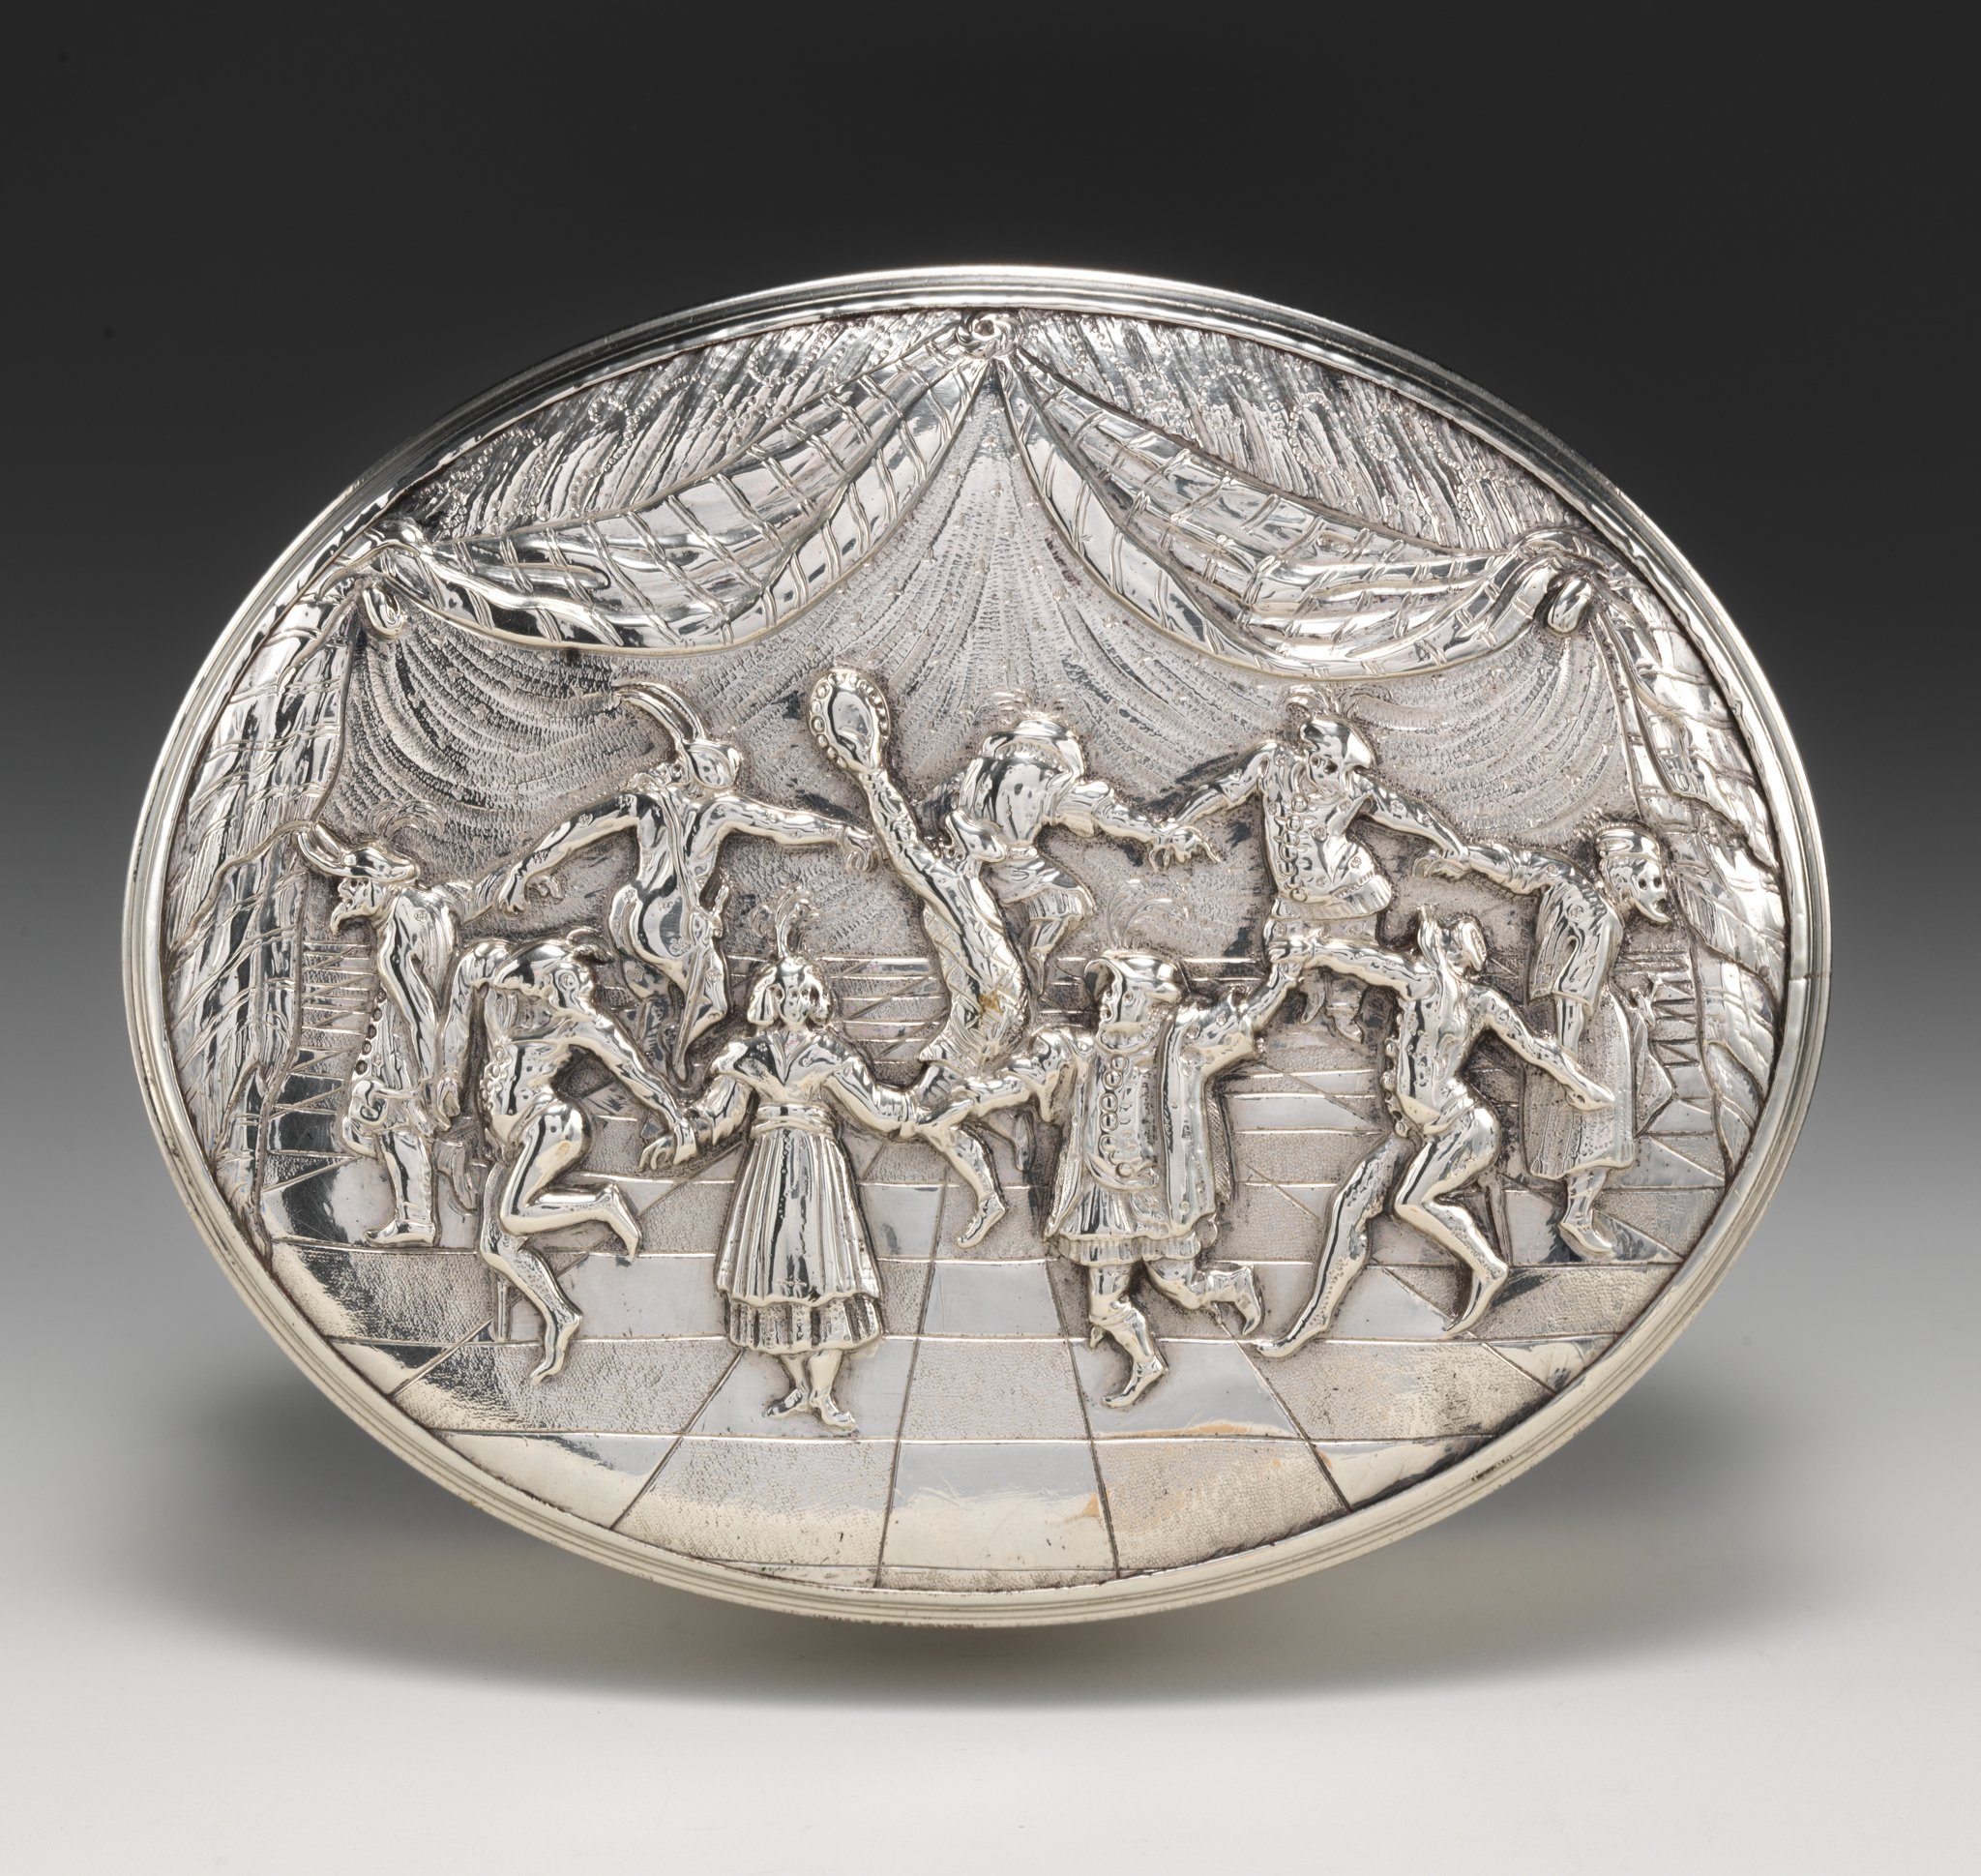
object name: tobacco box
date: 1701-1725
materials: silver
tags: human figures